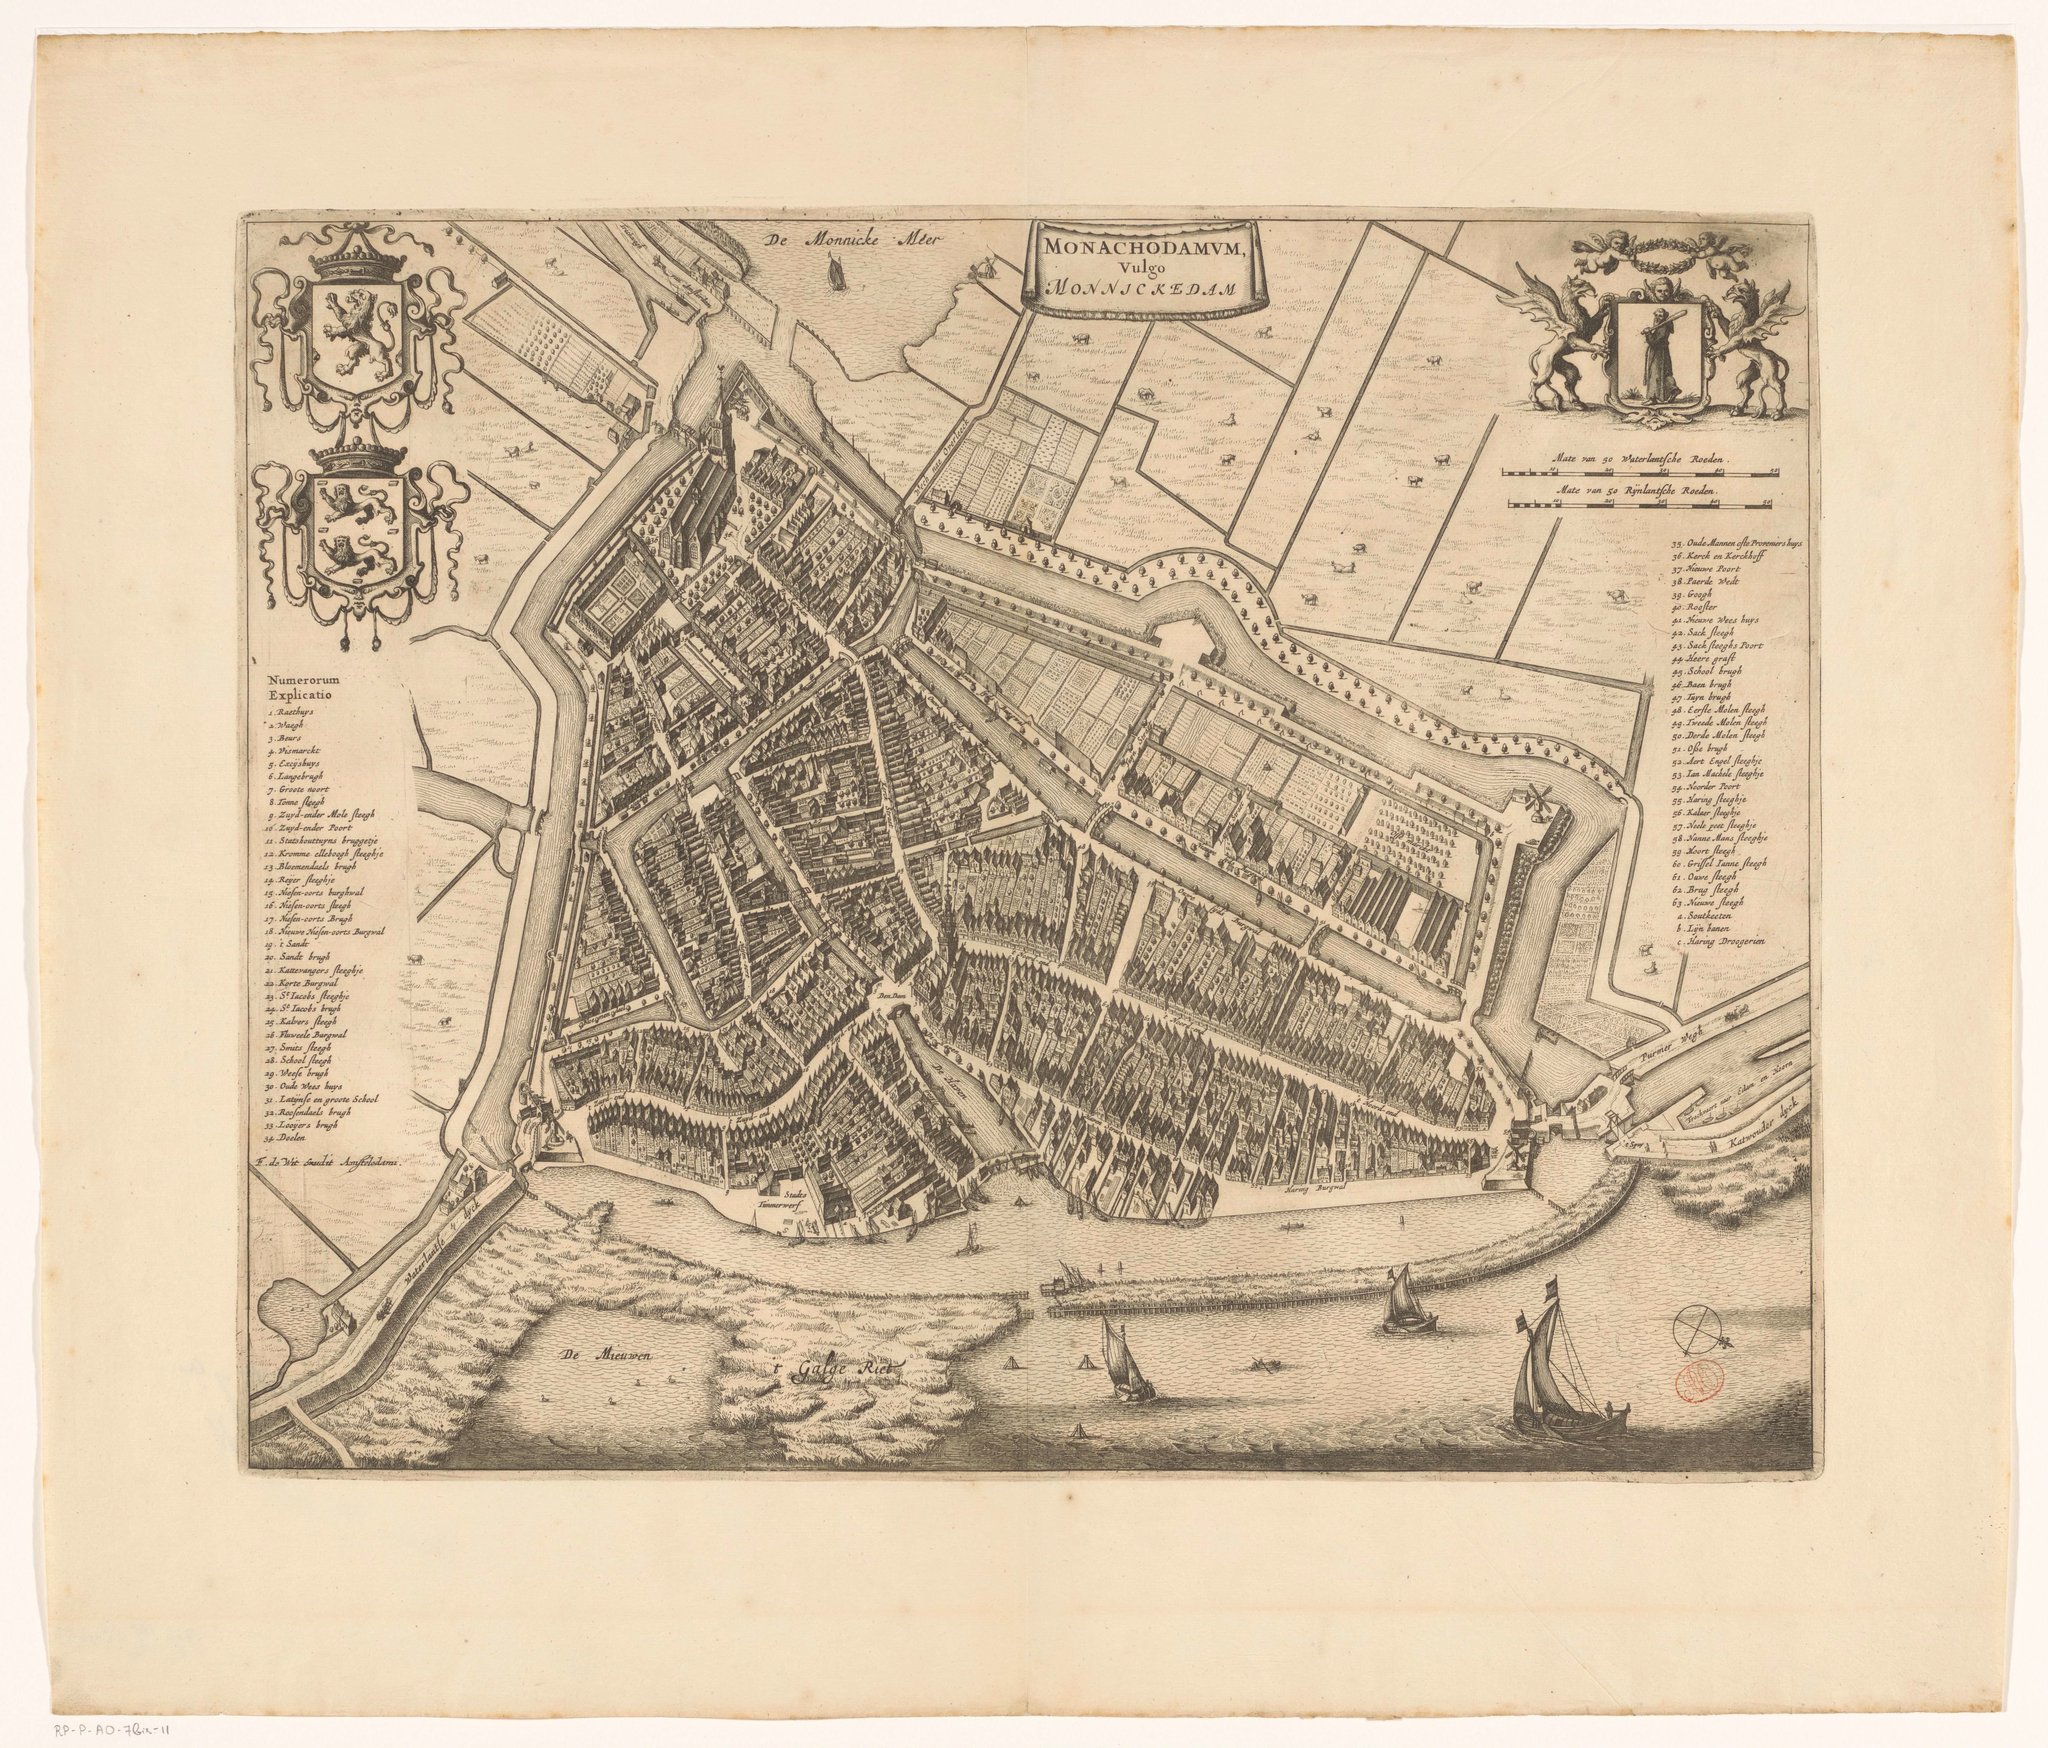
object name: book illustration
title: Plattegrond van Monnickendam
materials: paper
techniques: engraving, etching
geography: amsterdam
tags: coat of arms (as symbol of the state, etc.) (+ city; municipal), maps of cities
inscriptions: collector's mark: Lugt 195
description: Prent ook gebruikt in: Wagenaar, Jan. Tegenwoordige staat der Vereenigde Nederlanden, vyfde deel. Behelzende het vervolg der beschrijvinge van Holland. Met naauwkeurige plans der steden en printverbeeldingen versierd / Hedendaagsche historie, of tegenwoordige staat van alle volkeren; XVde deel (…). Amsterdam: Isaak Tirion, 1744, tussen p. 488 en 489. En in: Beknopte atlas, van omtrent honderd platte gronden der voornaamste vestingen, kasteelen en steden van Europa, en byzonder van de Nederlanden en eenige kolonien (…). Amsterdam: Compagnie van Boekverkopers, s.a. [na 1780].